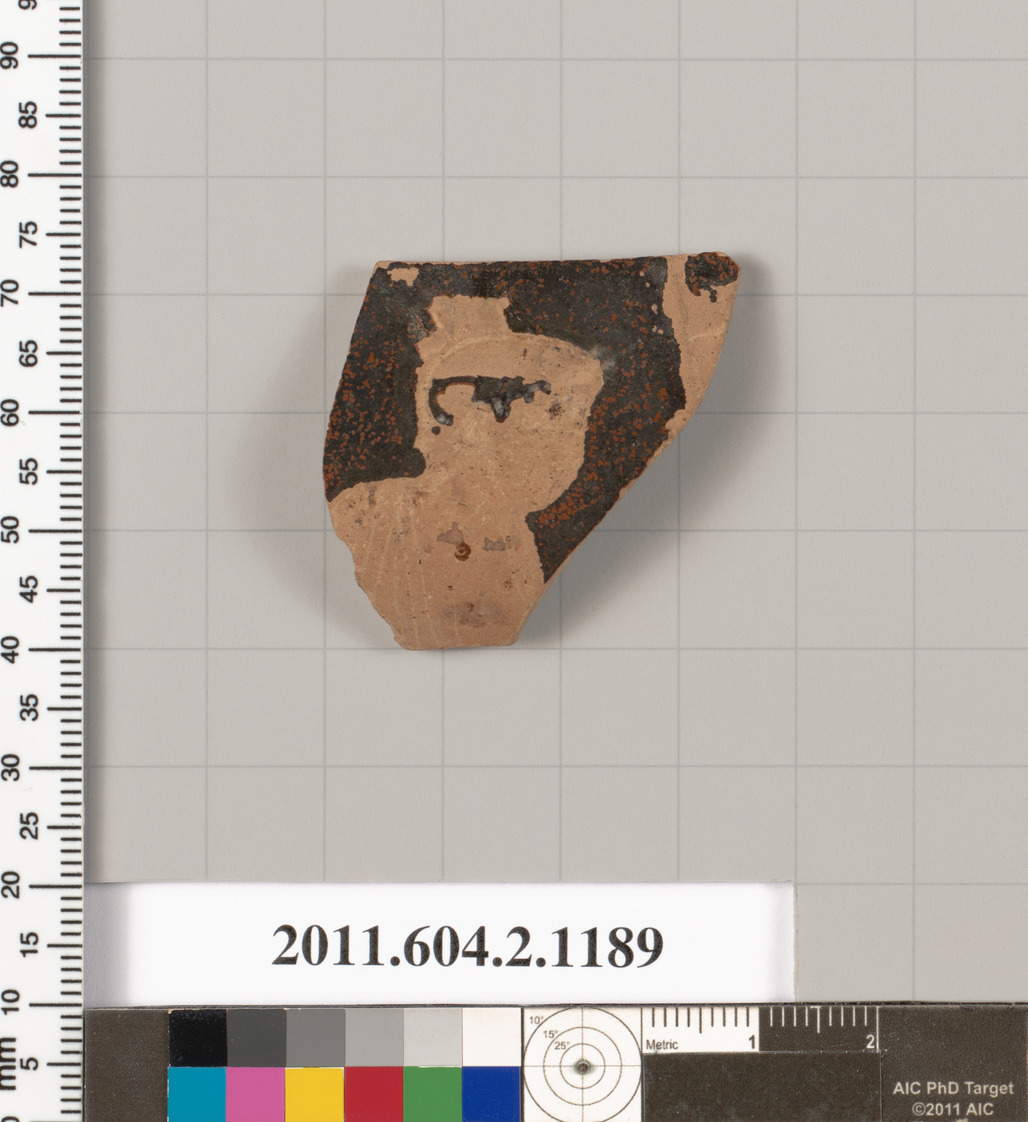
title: Terracotta fragment from an undetermined shape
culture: greek, attic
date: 450-401 BCE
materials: terracotta